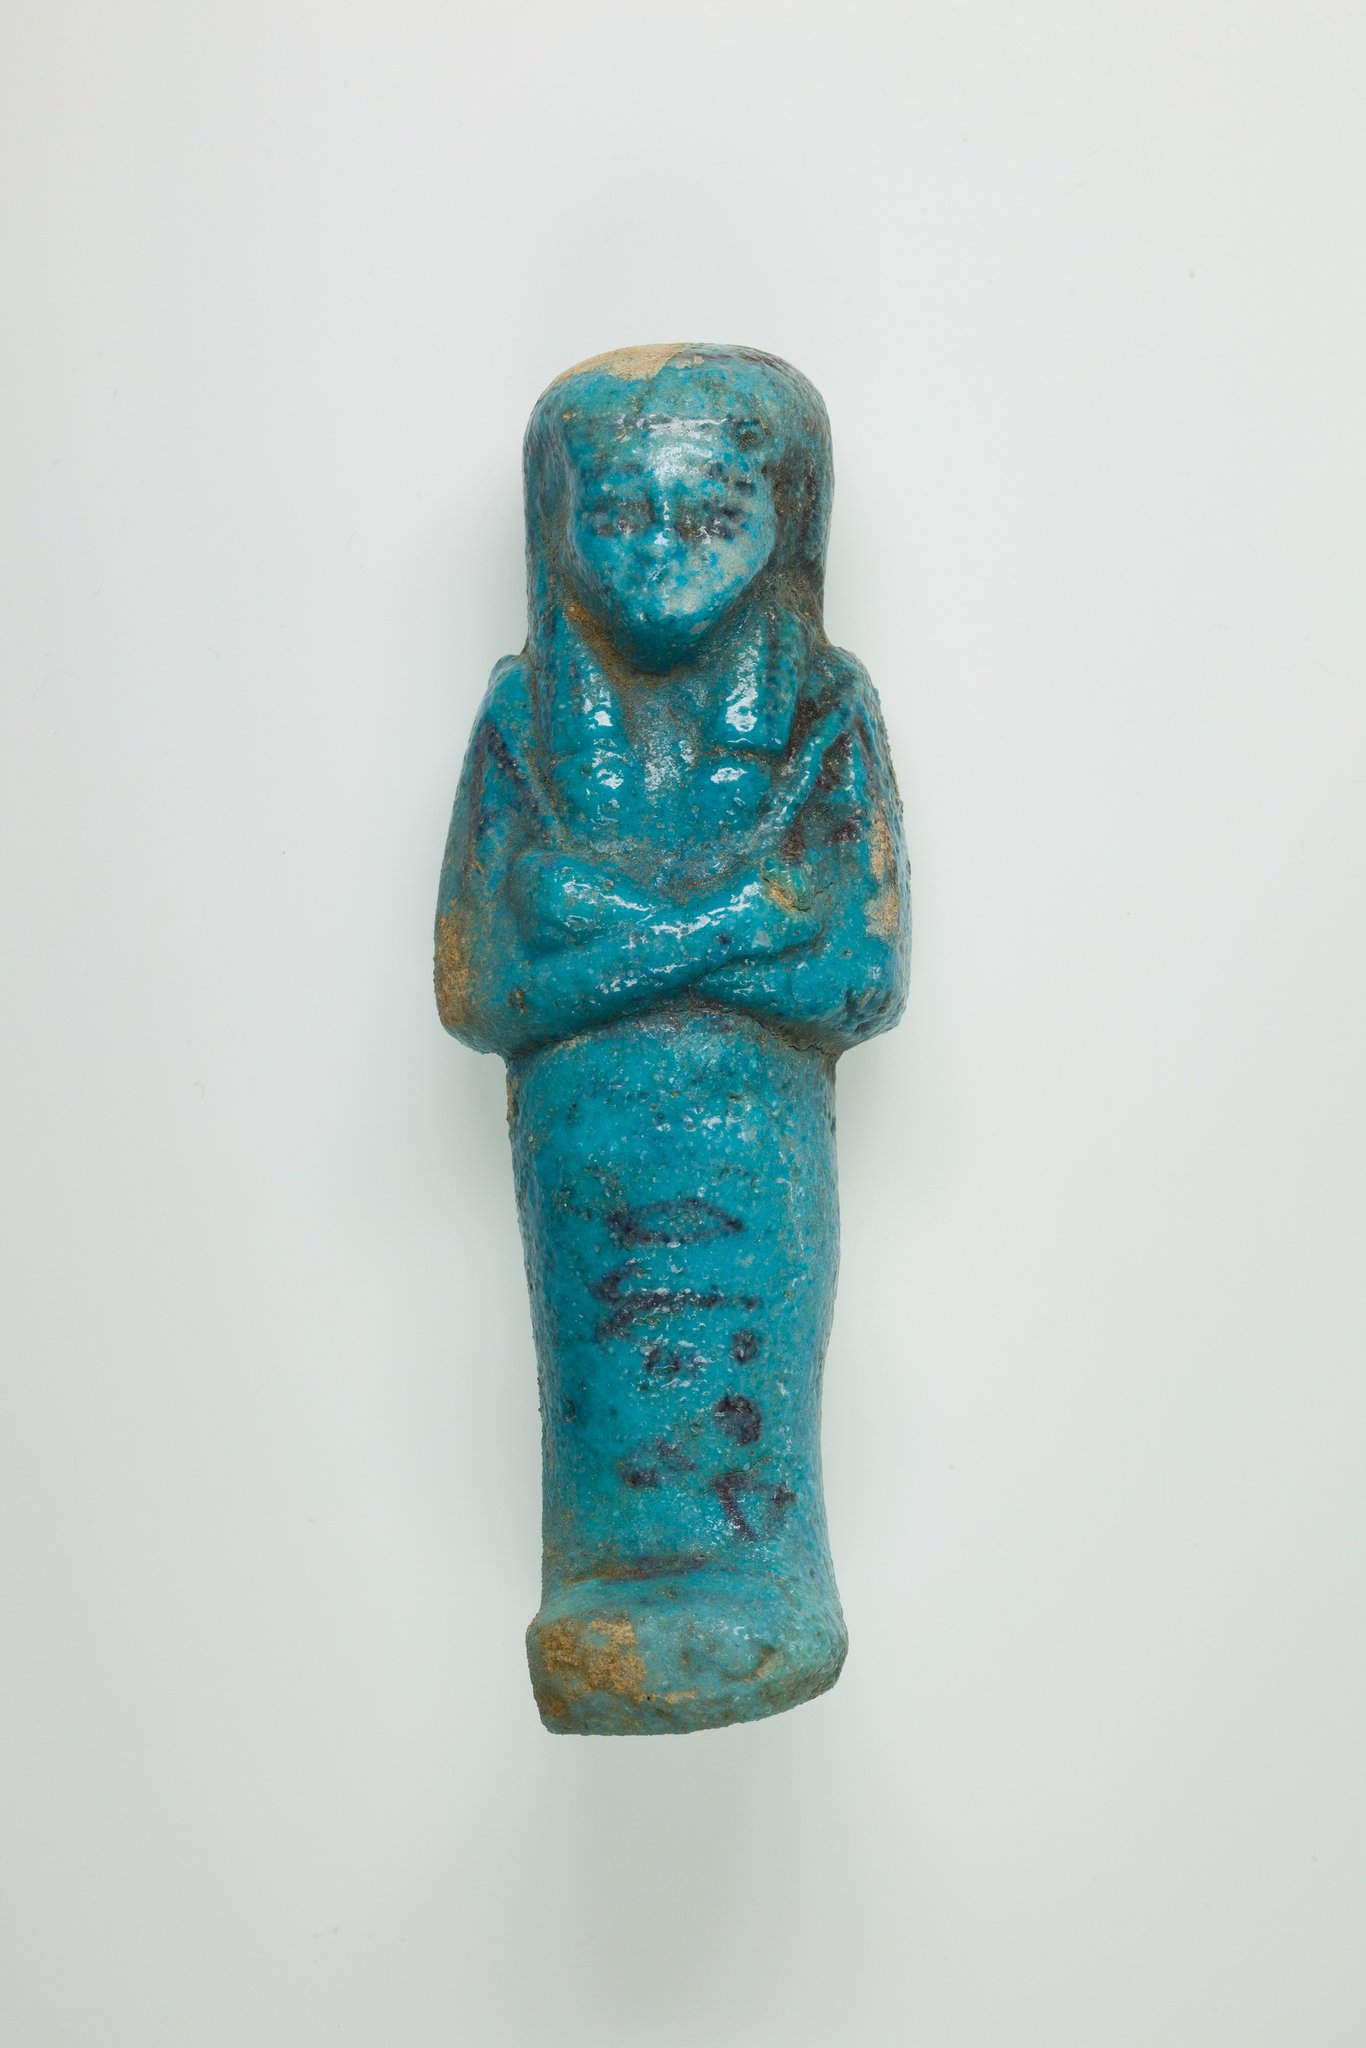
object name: shabti, henettawy c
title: Worker Shabti of Henettawy (C), Daughter of Isetemkheb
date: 990-970 BCE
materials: faience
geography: egypt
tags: hieroglyphs